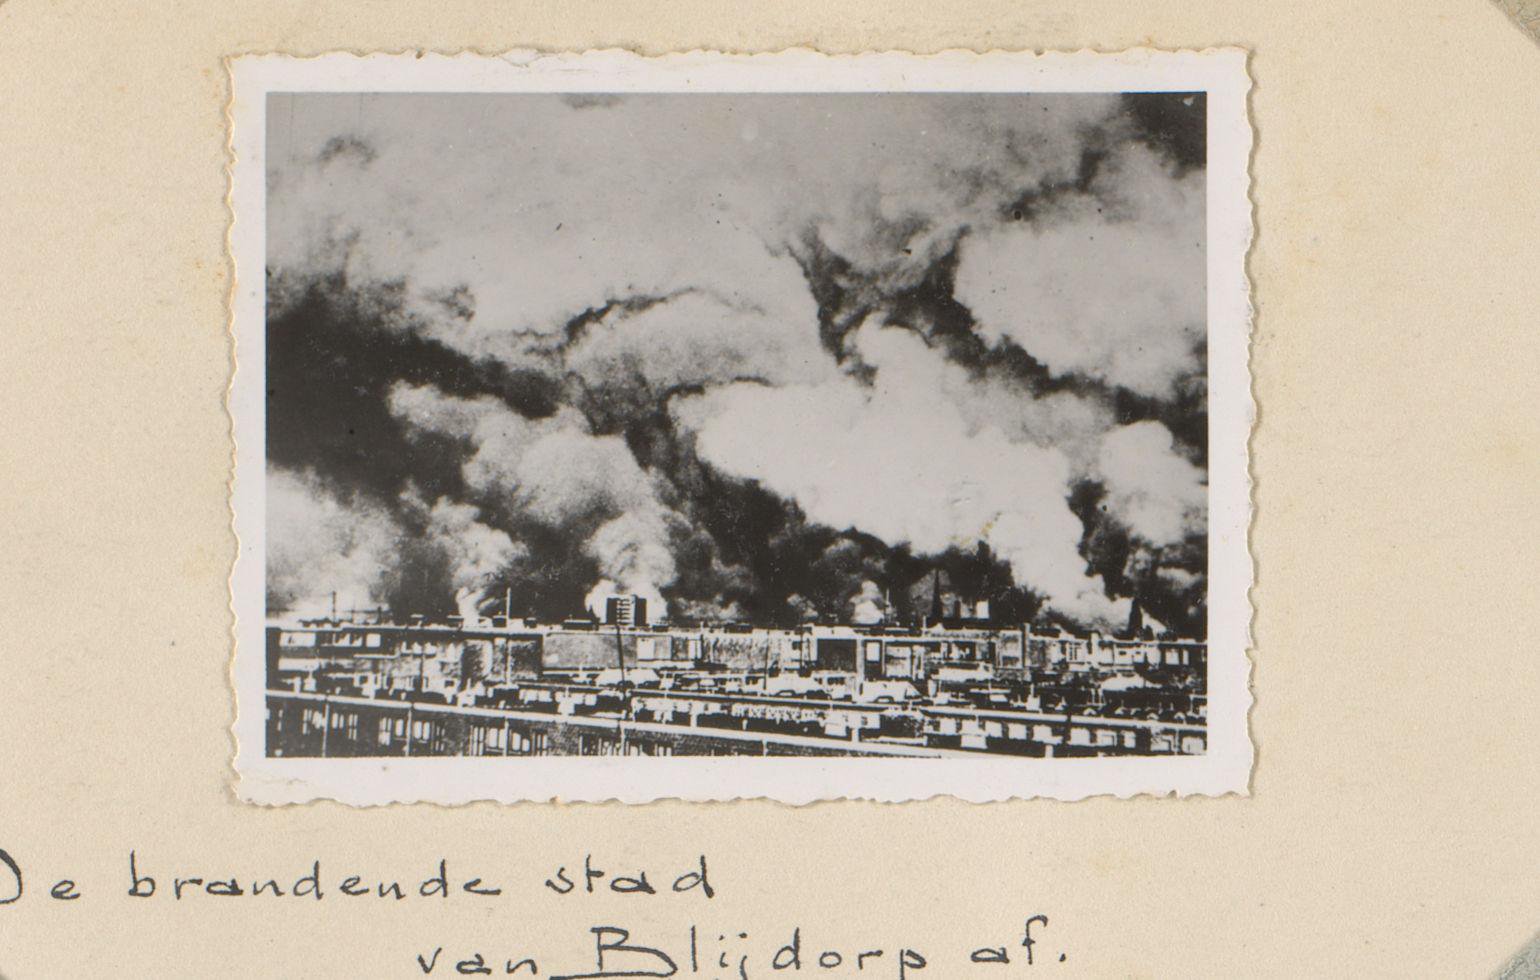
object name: photograph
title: Gezicht op Rotterdam met rookwolken boven de stad, vanaf Blijdorp gezien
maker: j. nolte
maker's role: fotograaf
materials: photographic support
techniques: gelatin silver print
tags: city-view in general; 'veduta', devastated, ruined place or city (~ warfare), rotterdam, rotterdam blitz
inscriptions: annotation: ‘De brandende stad/ van Blijdorp af’